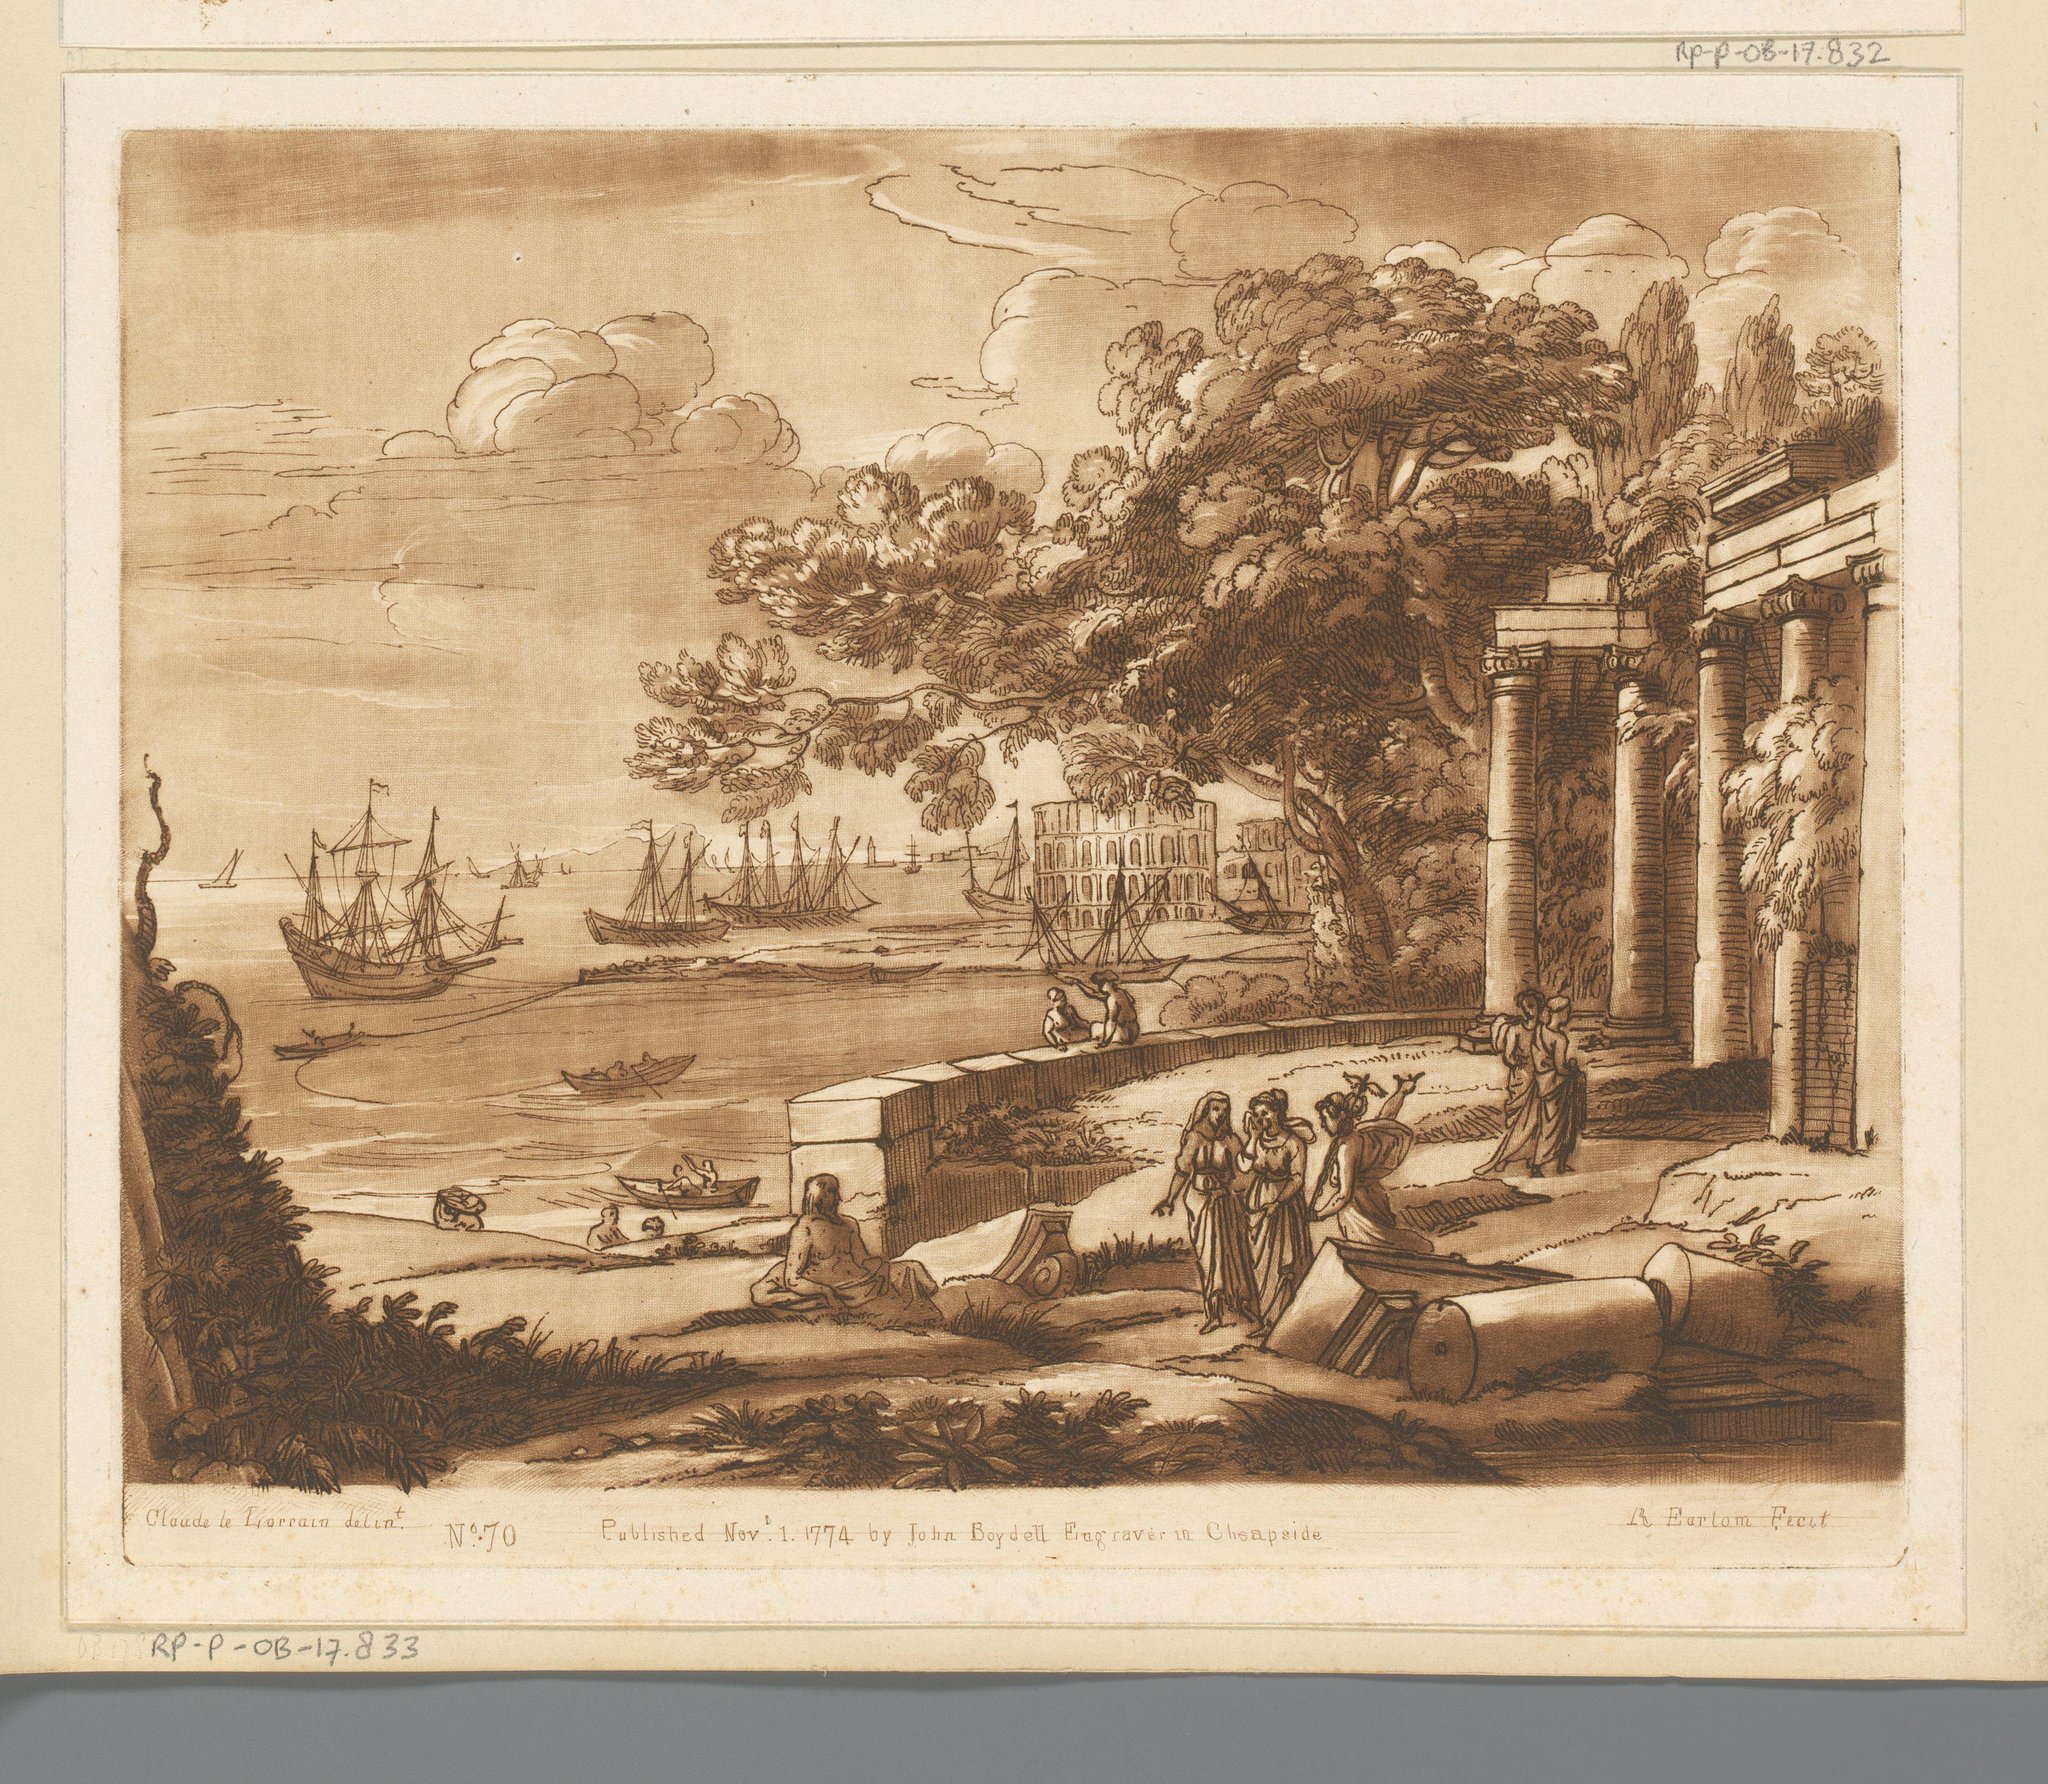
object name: print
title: Prenten naar tekeningen van Claude Lorrain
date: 1774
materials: paper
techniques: etching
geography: london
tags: coast - hh - ideal landscapes, mercury and herse, daughter of cecrops, landscape with ruins - ii - ideal landscapes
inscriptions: date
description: Vanaf 1774 publiceerde John Boydell tweehonderd prenten naar het tekeningenboek Liber Veritatis van Claude Lorrain, in het bezit van de hertogen van Cavendish. Deze prenten werden vanaf 1777 in twee volumes gebundeld uitgegeven.